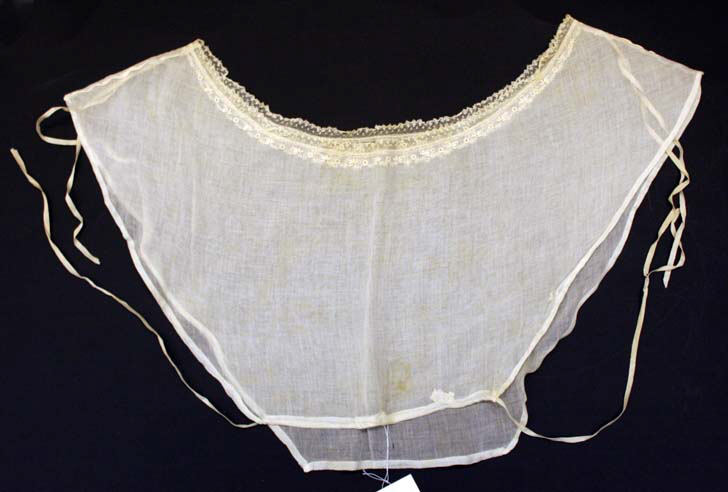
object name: fichu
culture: american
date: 1850-1859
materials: cotton